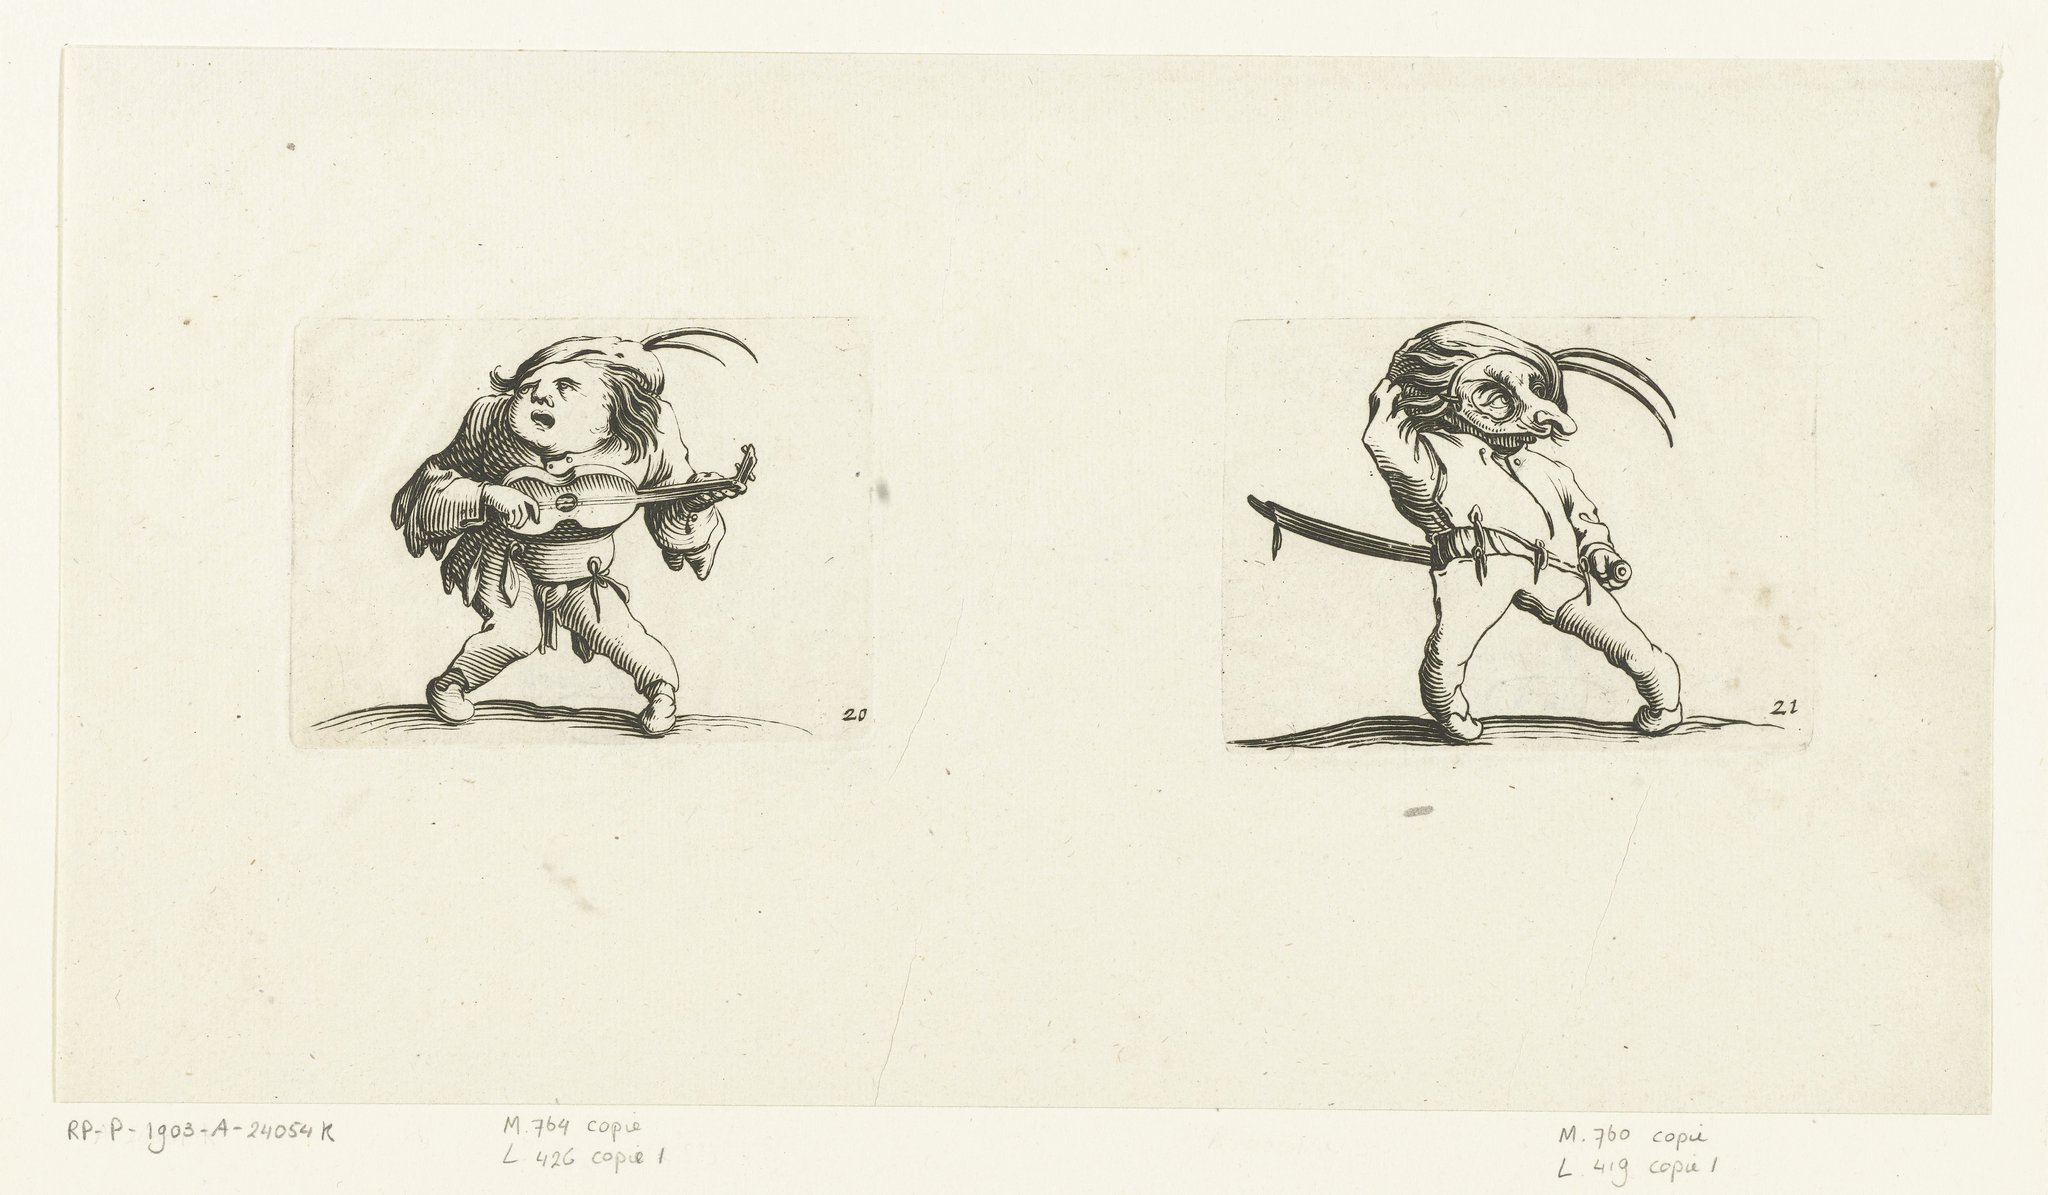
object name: print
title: Kleine mens (karikatuur) met gitaar; kleine mens (karikatuur) met zwaard en masker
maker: abraham bosse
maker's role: draughtsman, print maker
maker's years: 1602-1676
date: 1621-1676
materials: paper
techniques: engraving, etching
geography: paris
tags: mask, little people, hacking and thrusting weapons: sword, one person playing string instrument (plucked), cithern, mandolin, guitar, balalaika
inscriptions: collector's mark: Lugt 2228a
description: Links: kleine mens (karikatuur), van voren gezien, een gitaar bespelend, een muts met twee veren op het hoofd. Rechts: kleine mens (karikatuur), van voren gezien, een muts met twee veren op het hoofd, een masker voor het gezicht, de linkerhand aan het gevest van zijn zwaard. Deze beide prenten, naast elkaar op 1 blad gedrukt, zijn onderdeel van een serie van 21 prenten (op 11 bladen gedrukt, dus m.u.v. de titelprent steeds 2 platen per blad) met groteske figuren; vrijwel al die figuren zijn karikaturen van kleine mensen, velen zijn gebocheld.